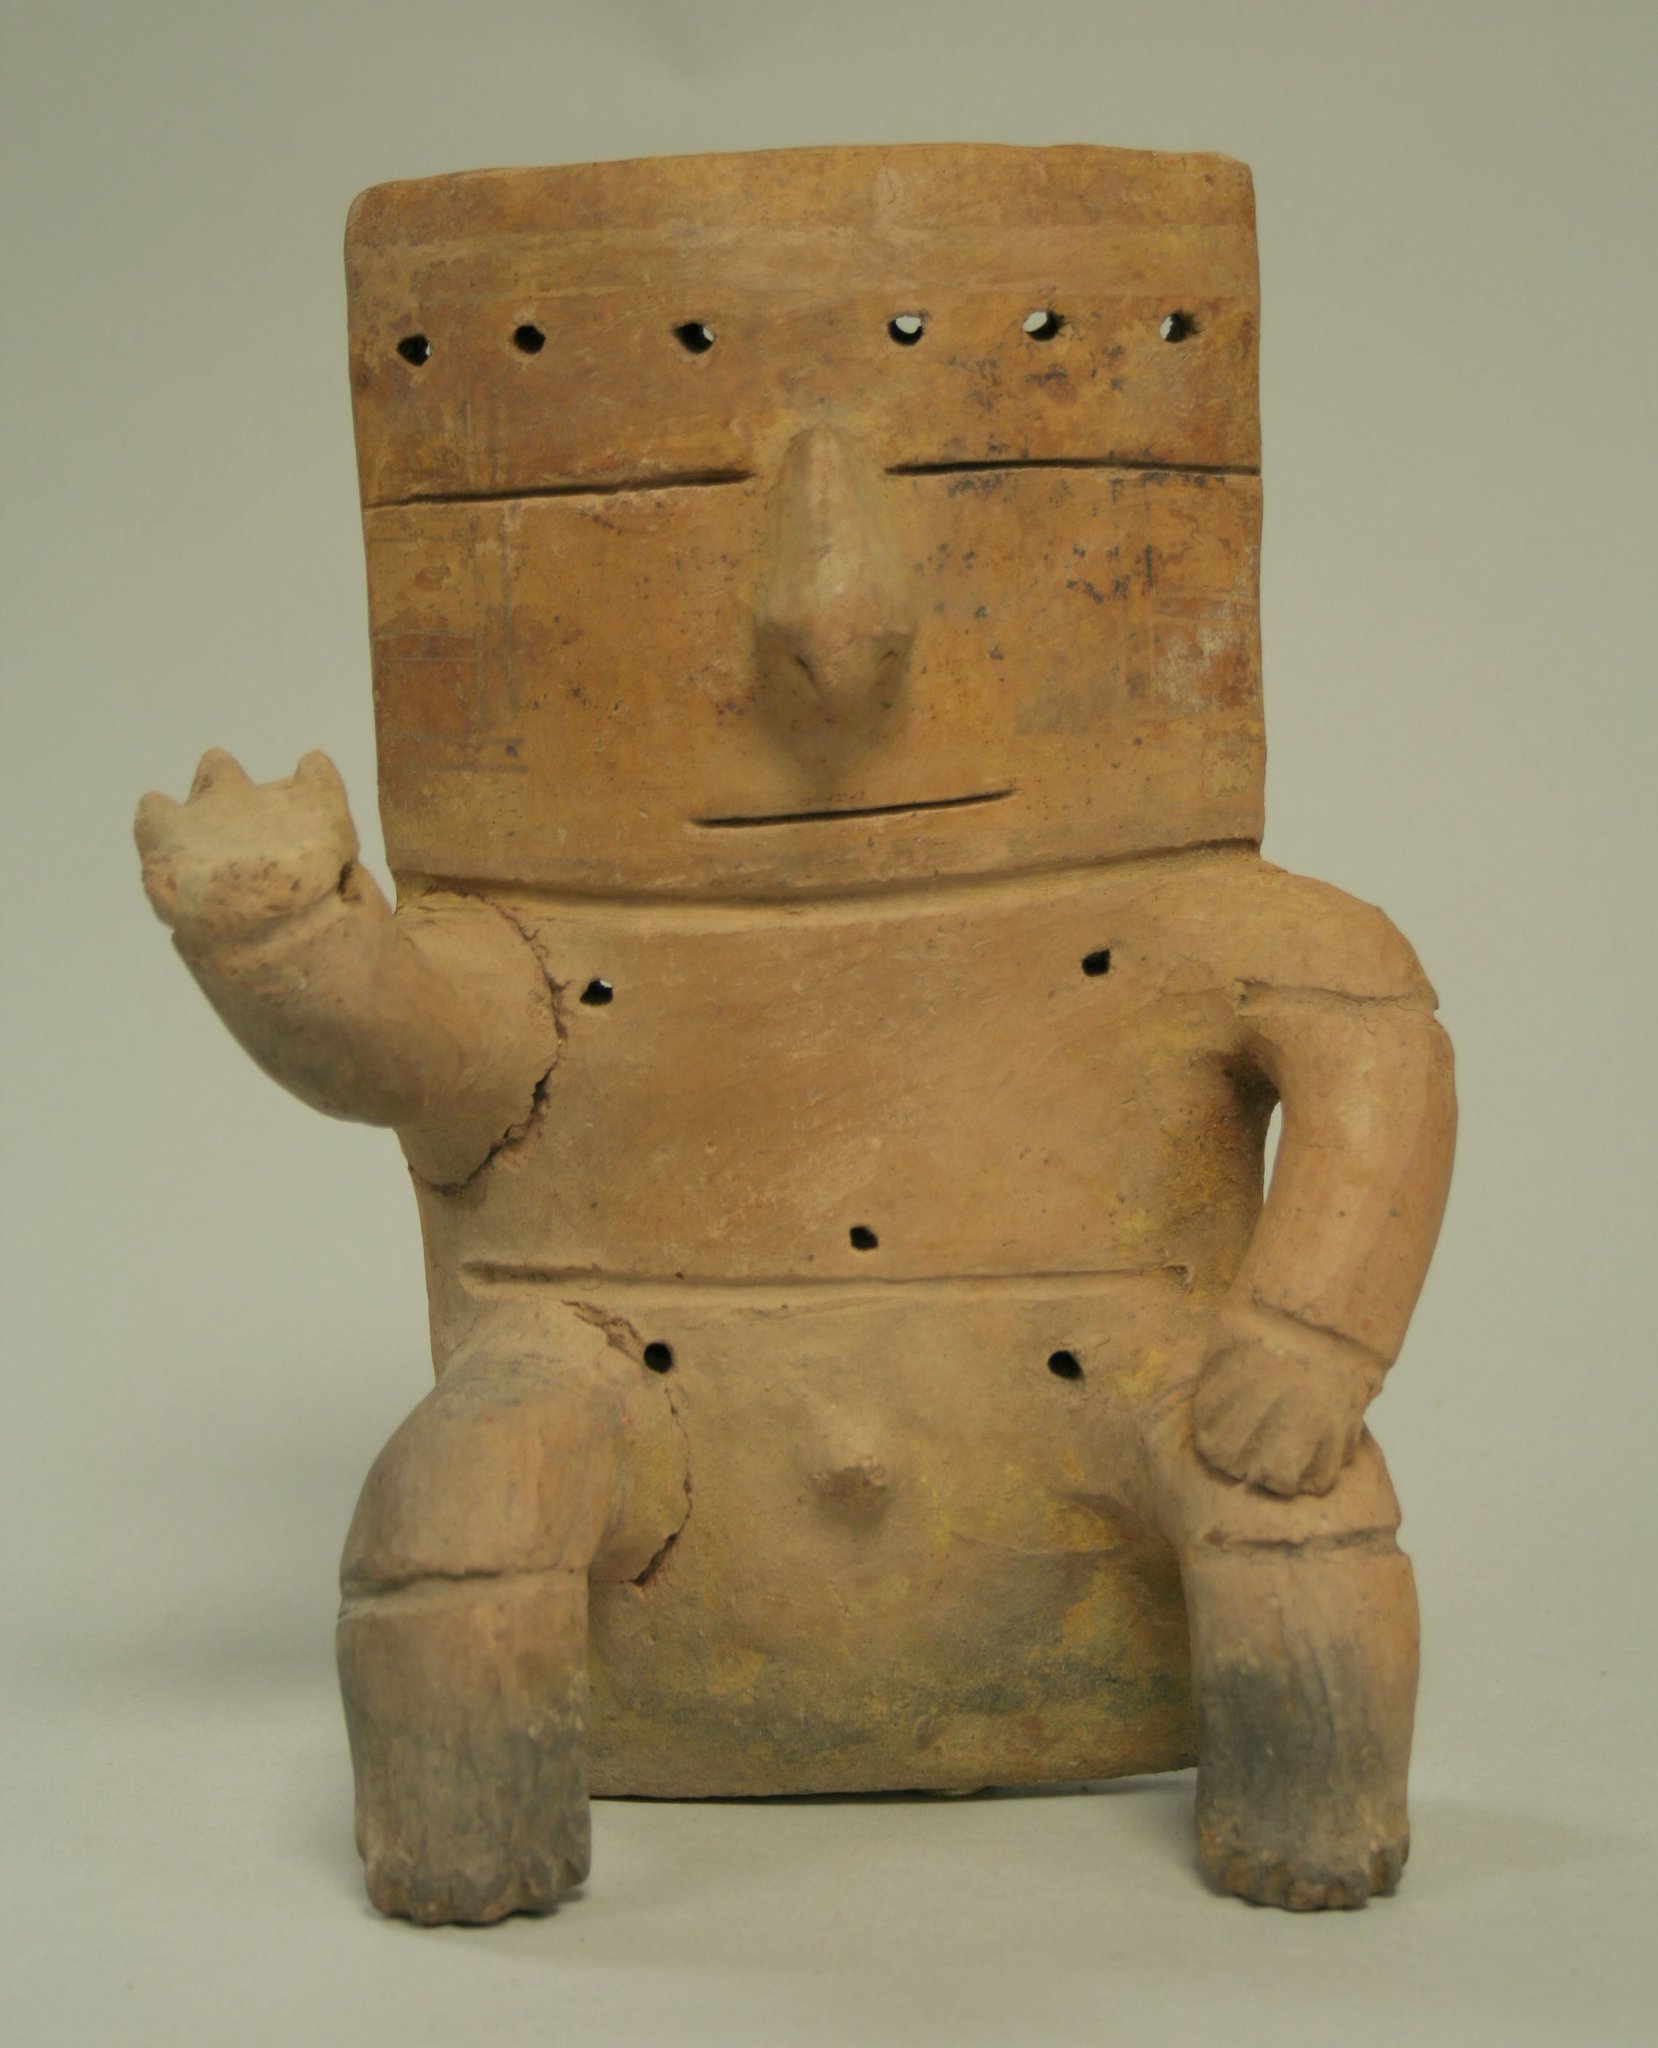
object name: male figure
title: Seated Male Figure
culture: quimbaya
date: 1001-1200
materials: ceramic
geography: colombia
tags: men